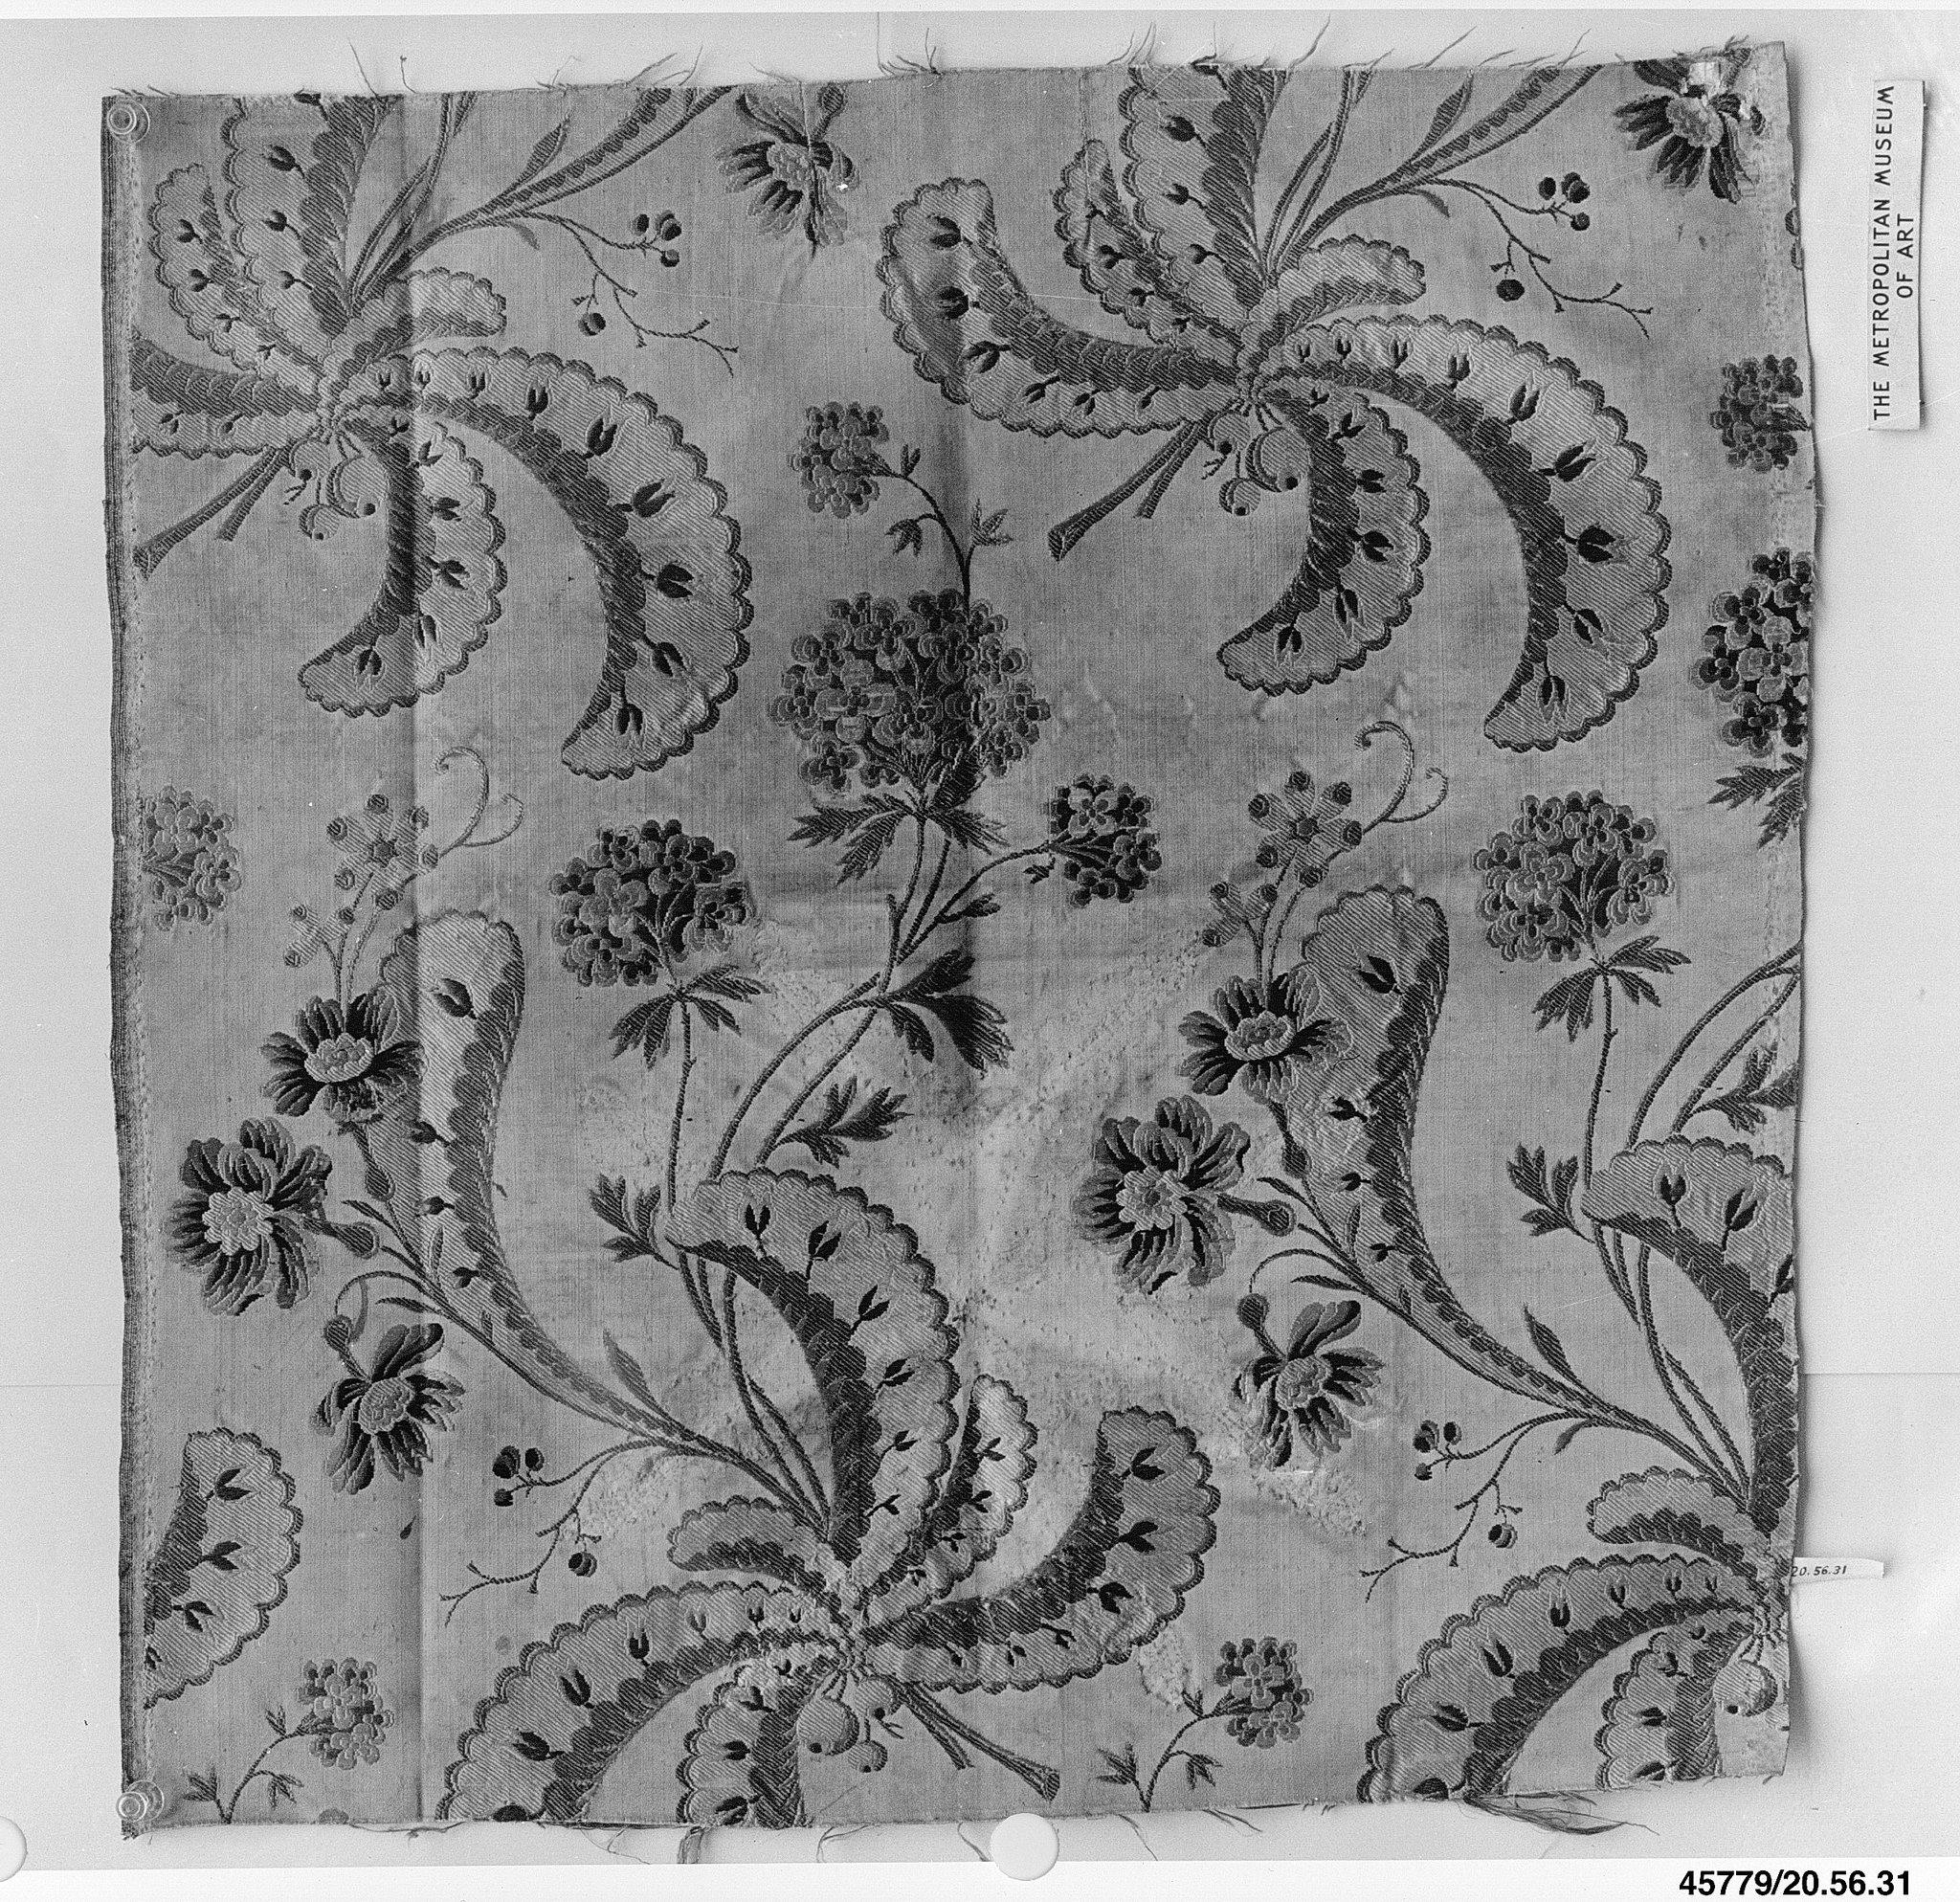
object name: piece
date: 1745-1750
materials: silk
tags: flowers,leaves